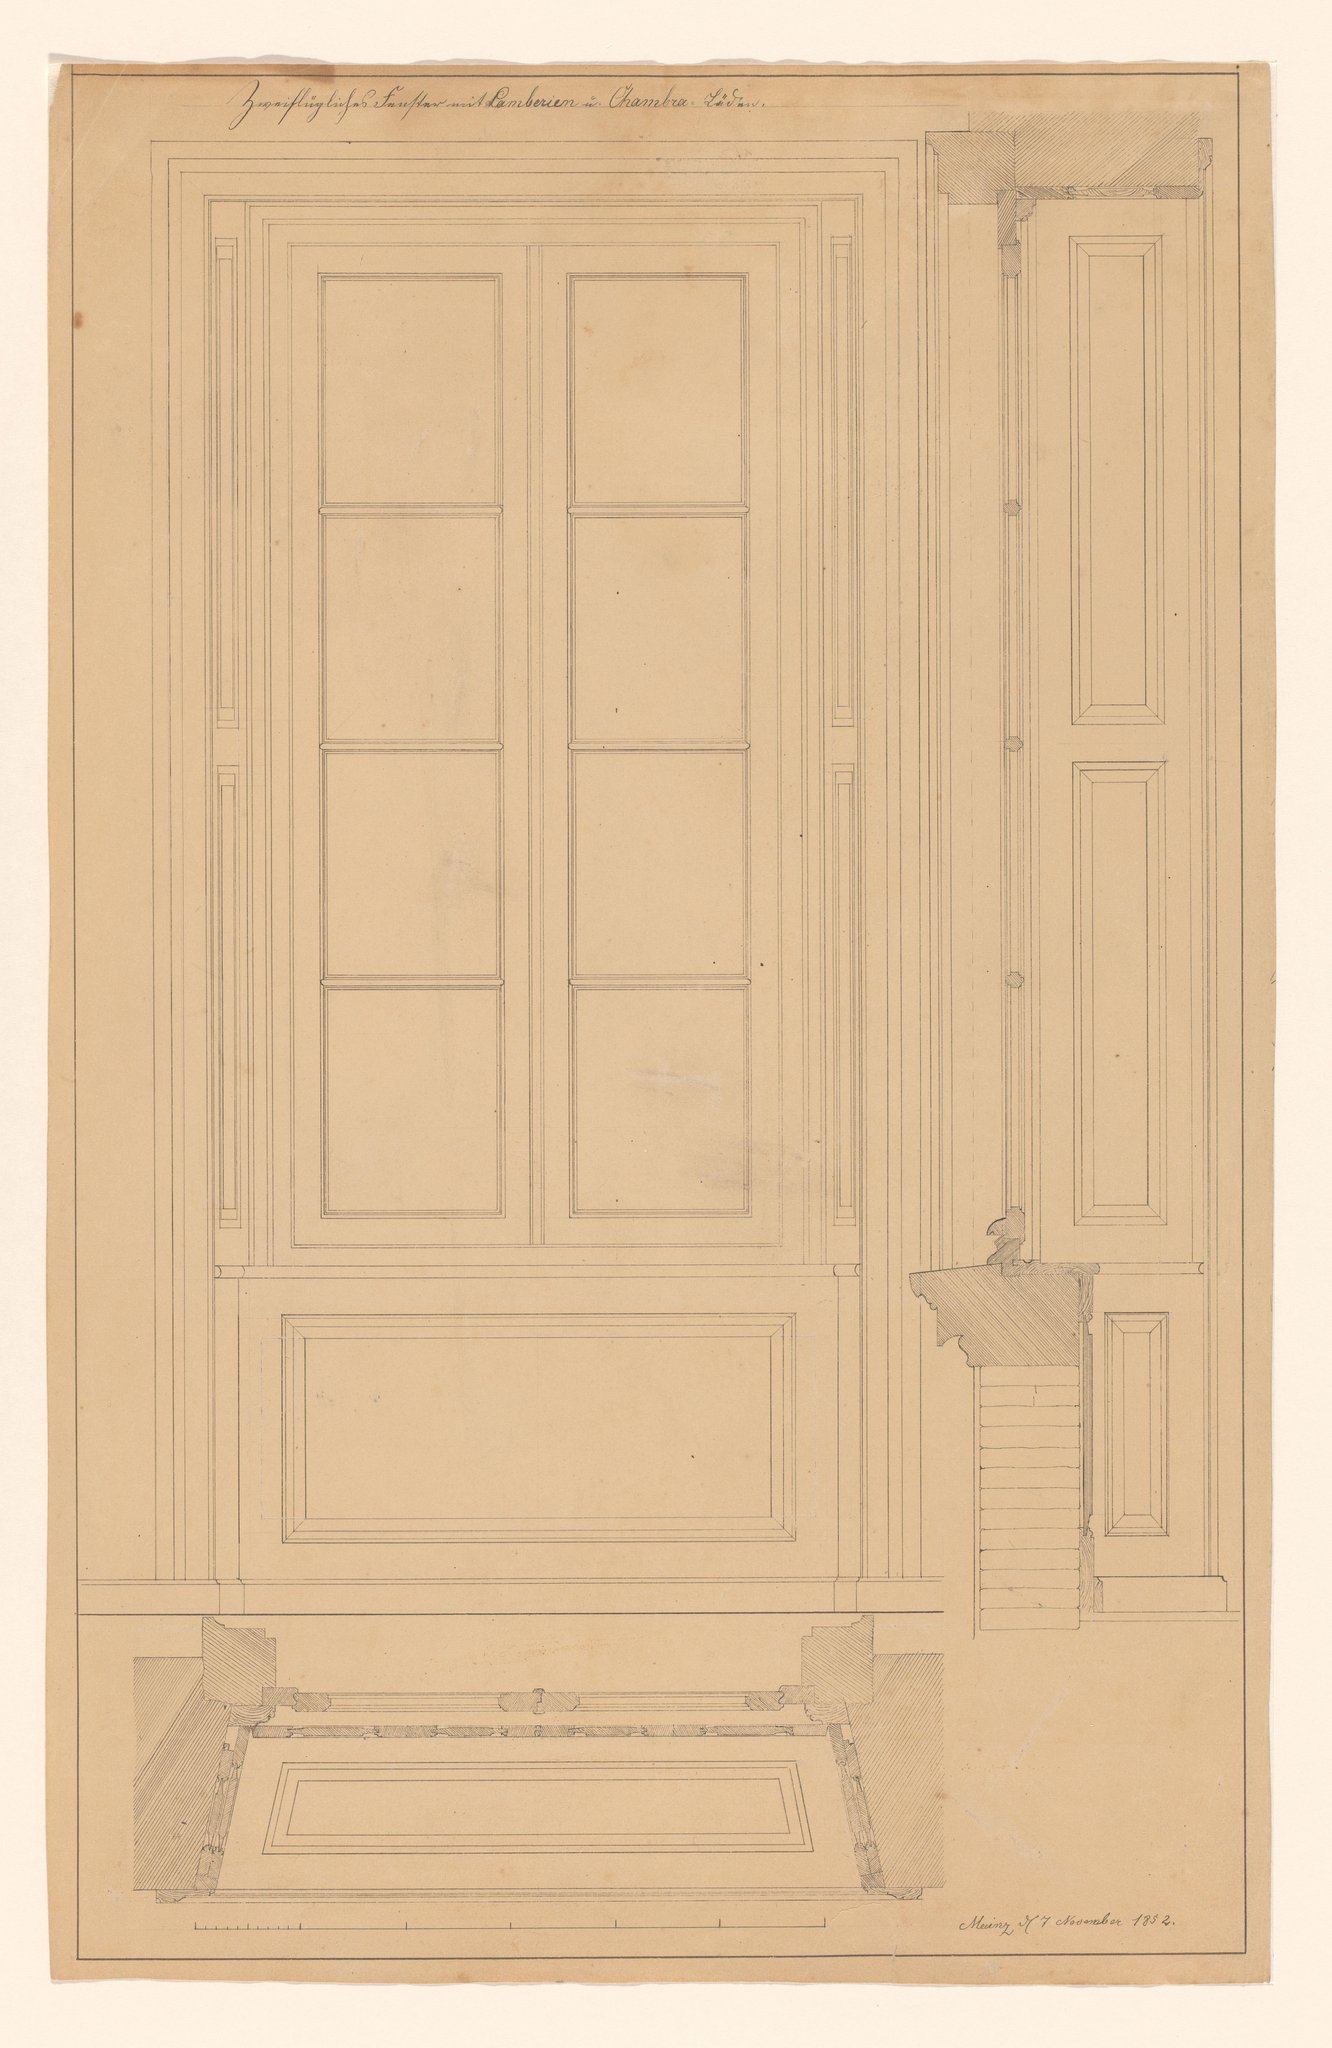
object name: drawing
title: Ontwerp voor een dubbel raam met lambrisering, met zijaanzicht en plattegrond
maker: b. winghofer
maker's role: draughtsman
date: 1852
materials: graphite, ink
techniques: drawing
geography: mainz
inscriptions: inscription: ‘Zweiflügliches Fenster mit Lamberien und Chambra-Läden’, size: ‘maatverdeling’, watermark: ‘J WH[ATMAN]’, date: ‘Mainz den 7 November 1852’